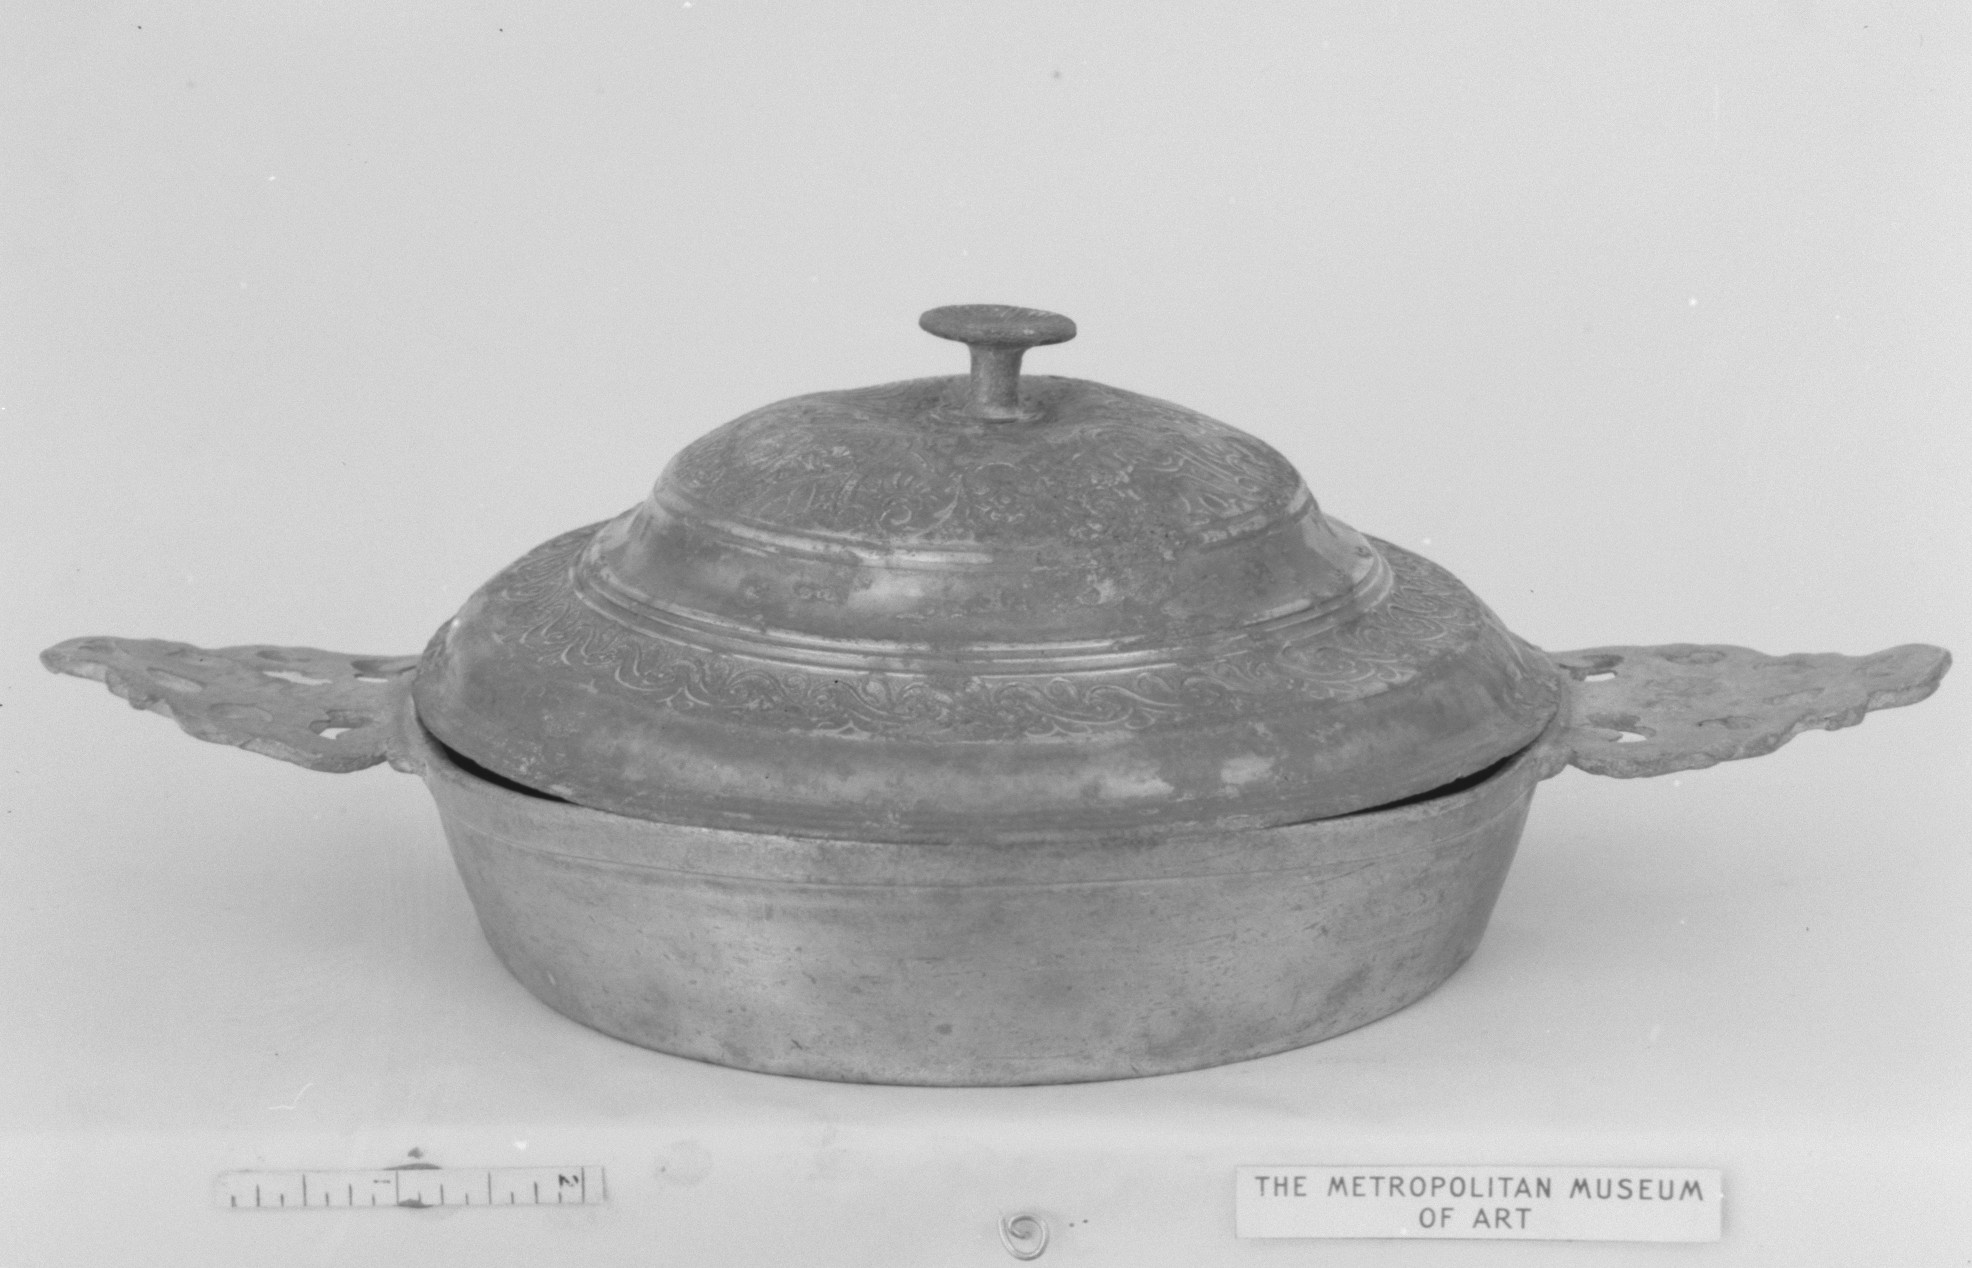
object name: broth bowl with cover écuelle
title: Broth bowl with cover (écuelle)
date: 1701-1750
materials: pewter